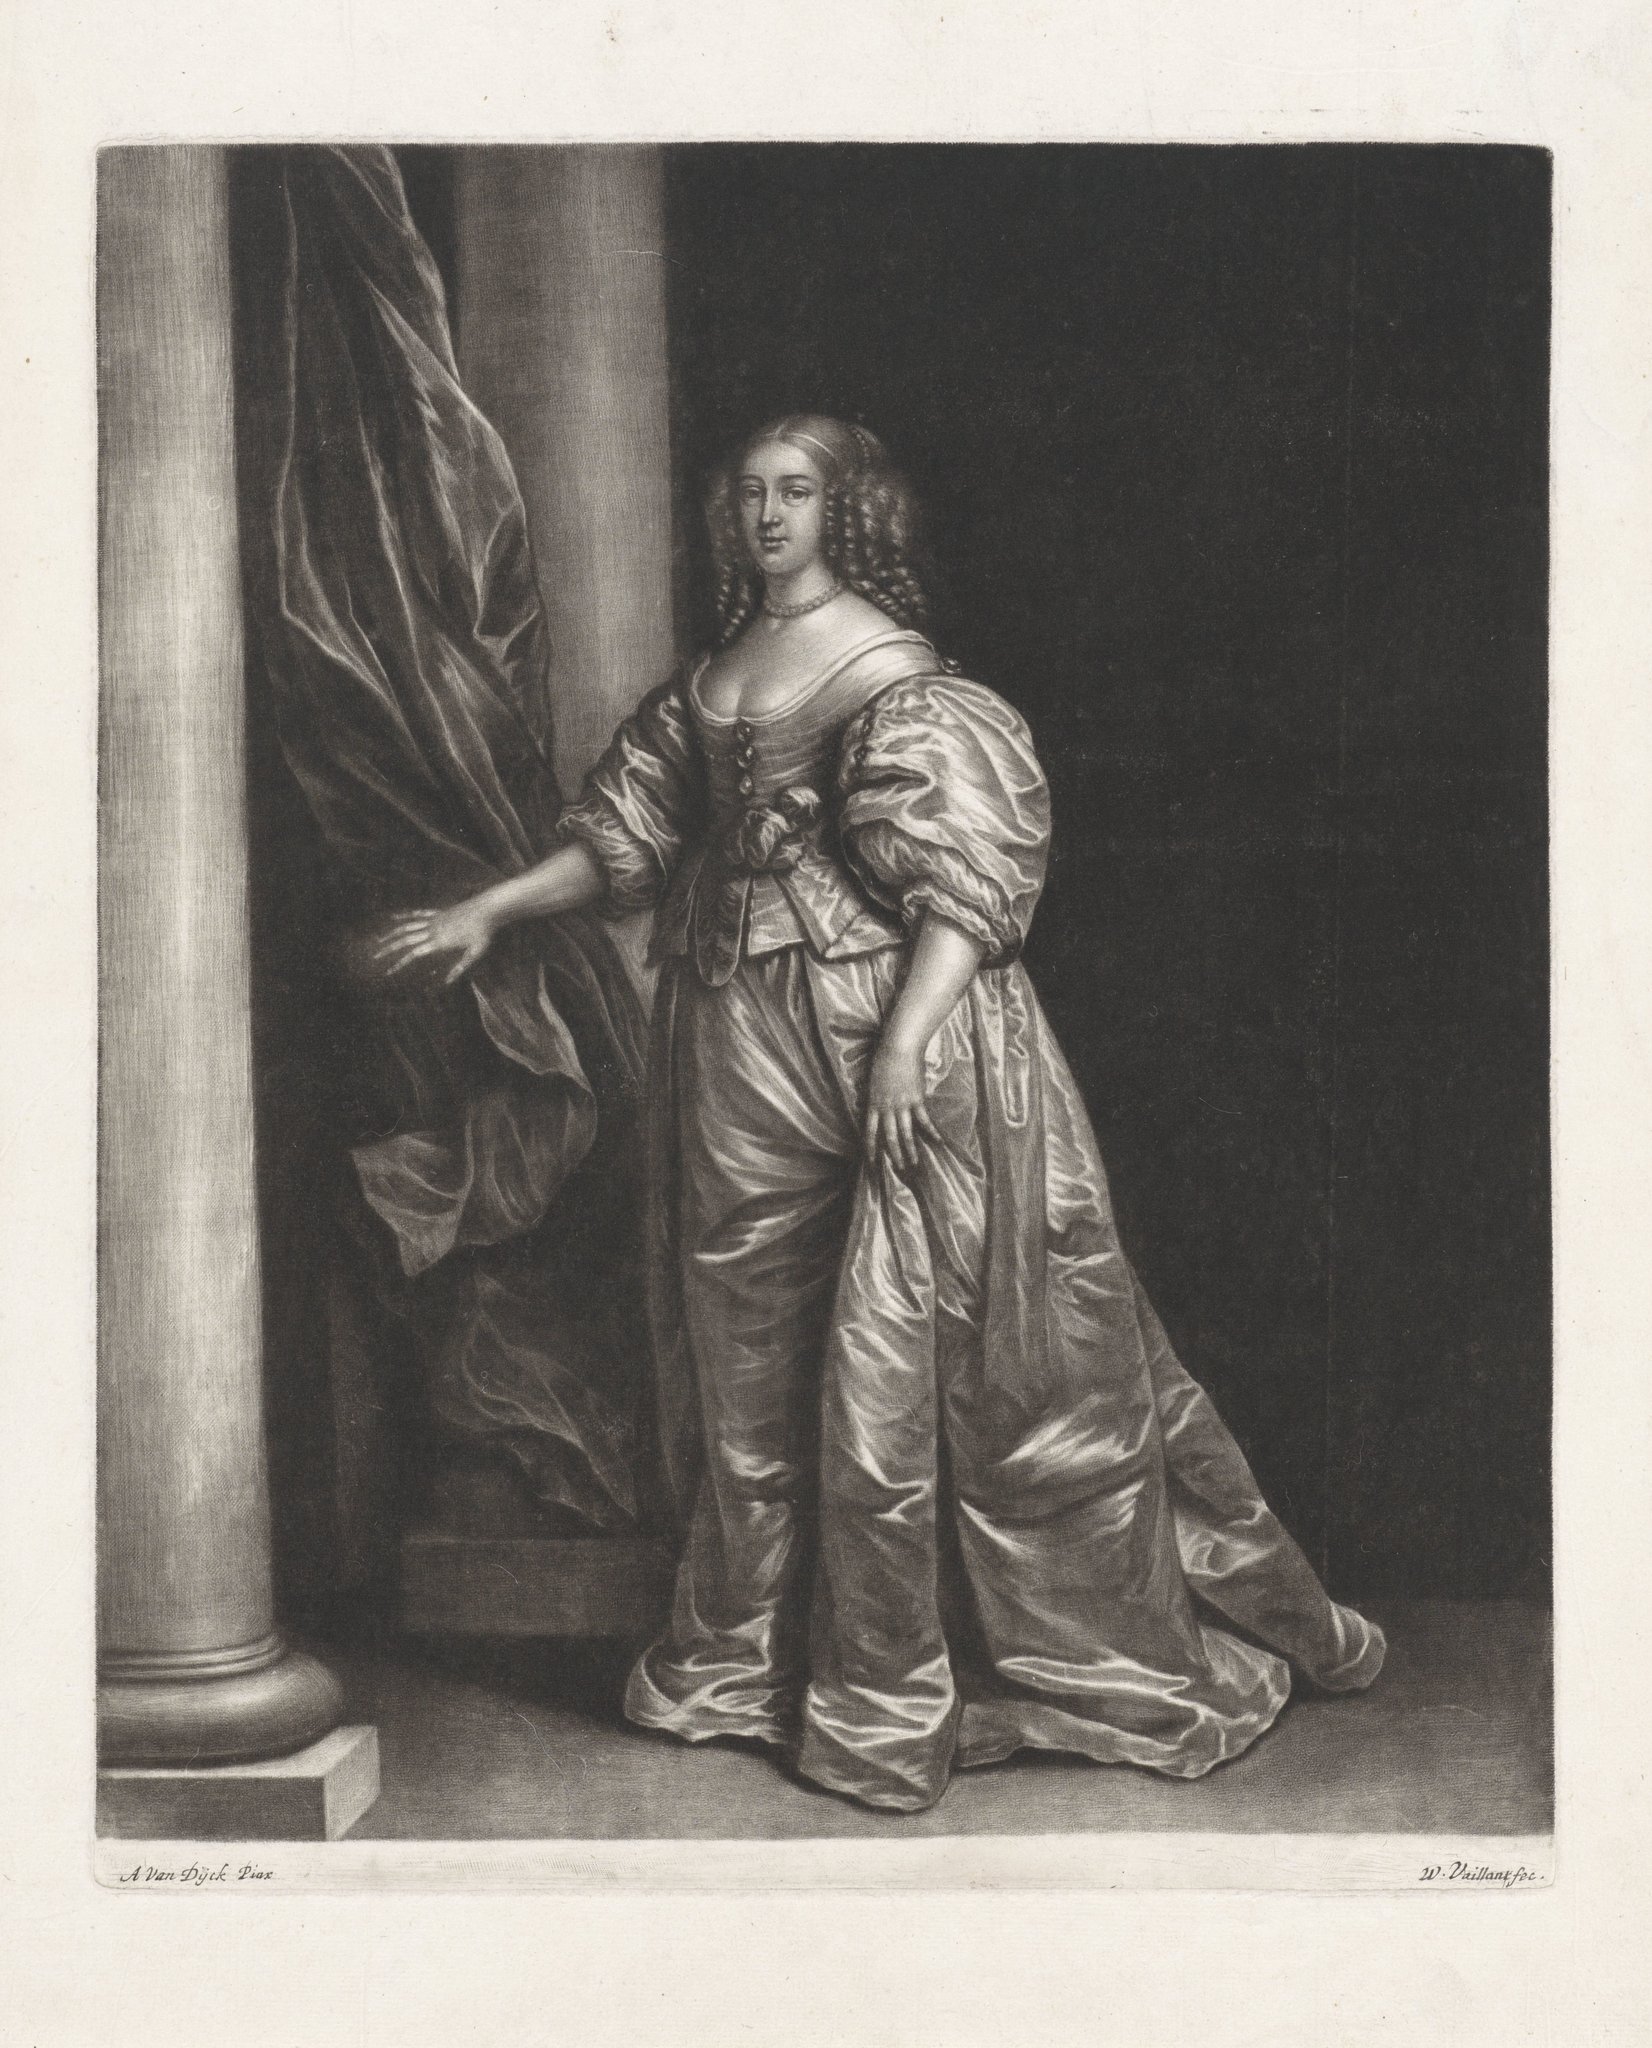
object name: print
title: Portret van een vrouw bij een gordijn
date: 1658-1677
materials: paper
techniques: mezzotint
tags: necklace (+ women's clothes)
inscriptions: collector's mark: Lugt 240